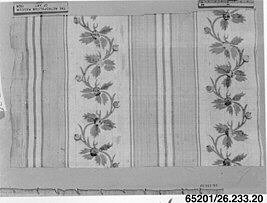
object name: fragment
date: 1801-1833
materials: silk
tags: flowers,leaves